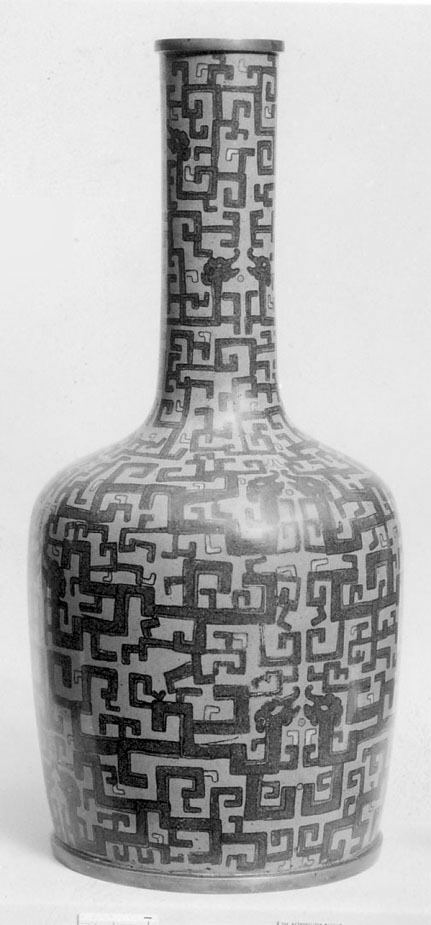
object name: bottle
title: Bottle (one of a pair)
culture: chinese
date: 1662-1722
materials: copper, enamel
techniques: enamel